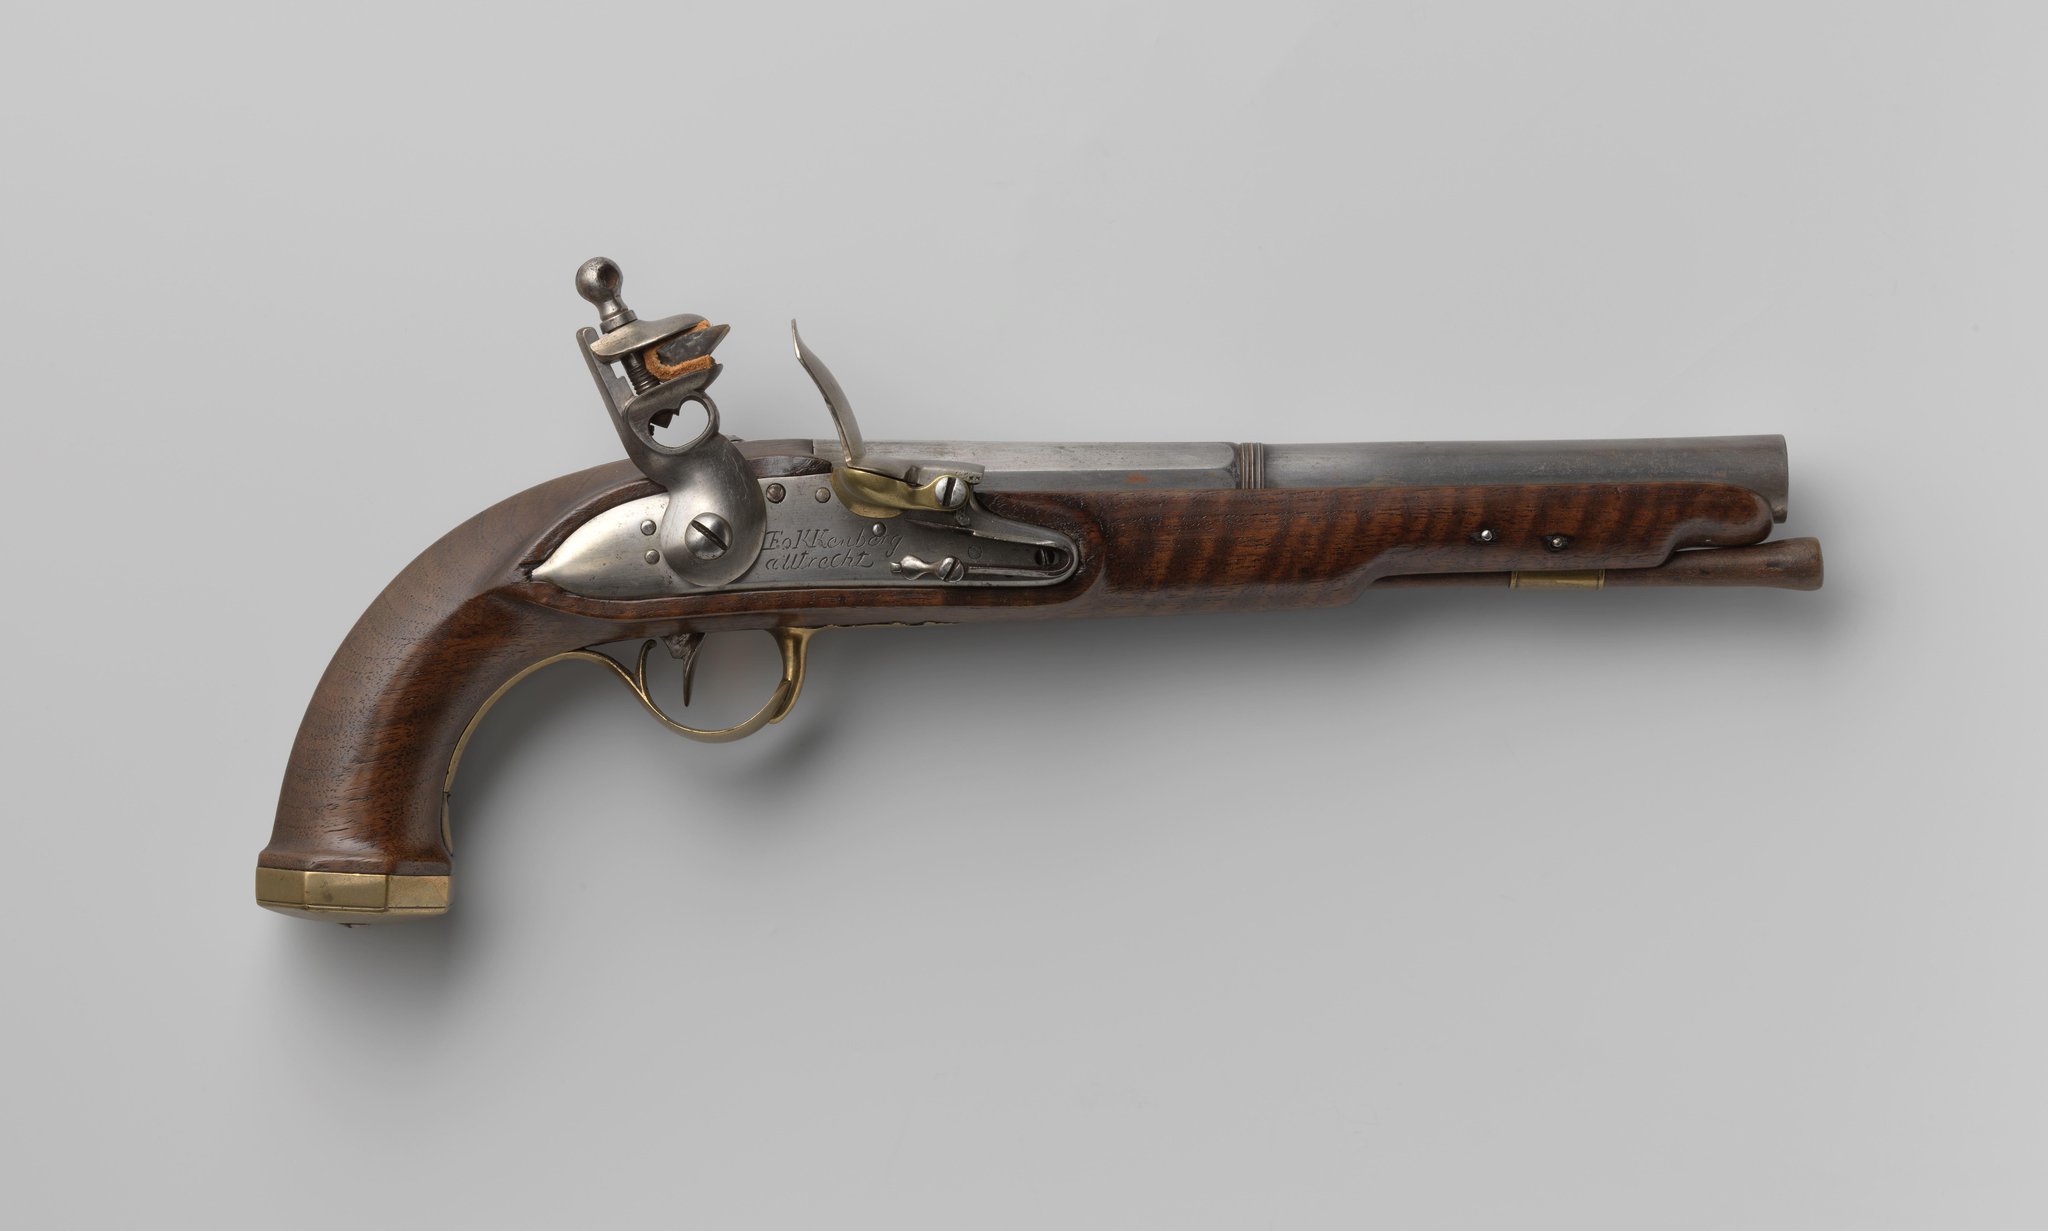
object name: flintlock pistol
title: Vuursteenpistool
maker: jan dirk fokkenberg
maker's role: geweermaker, pistoolmaker, winkelier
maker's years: 1744-1812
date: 1790-1795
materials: brass, stone, iron, wood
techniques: printing, engraving, faceting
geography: utrecht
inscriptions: mark: ‘Y // RUS // TA (St. 960)’, inscription: ‘FoKKenberg // a Utrecht; G.S.’